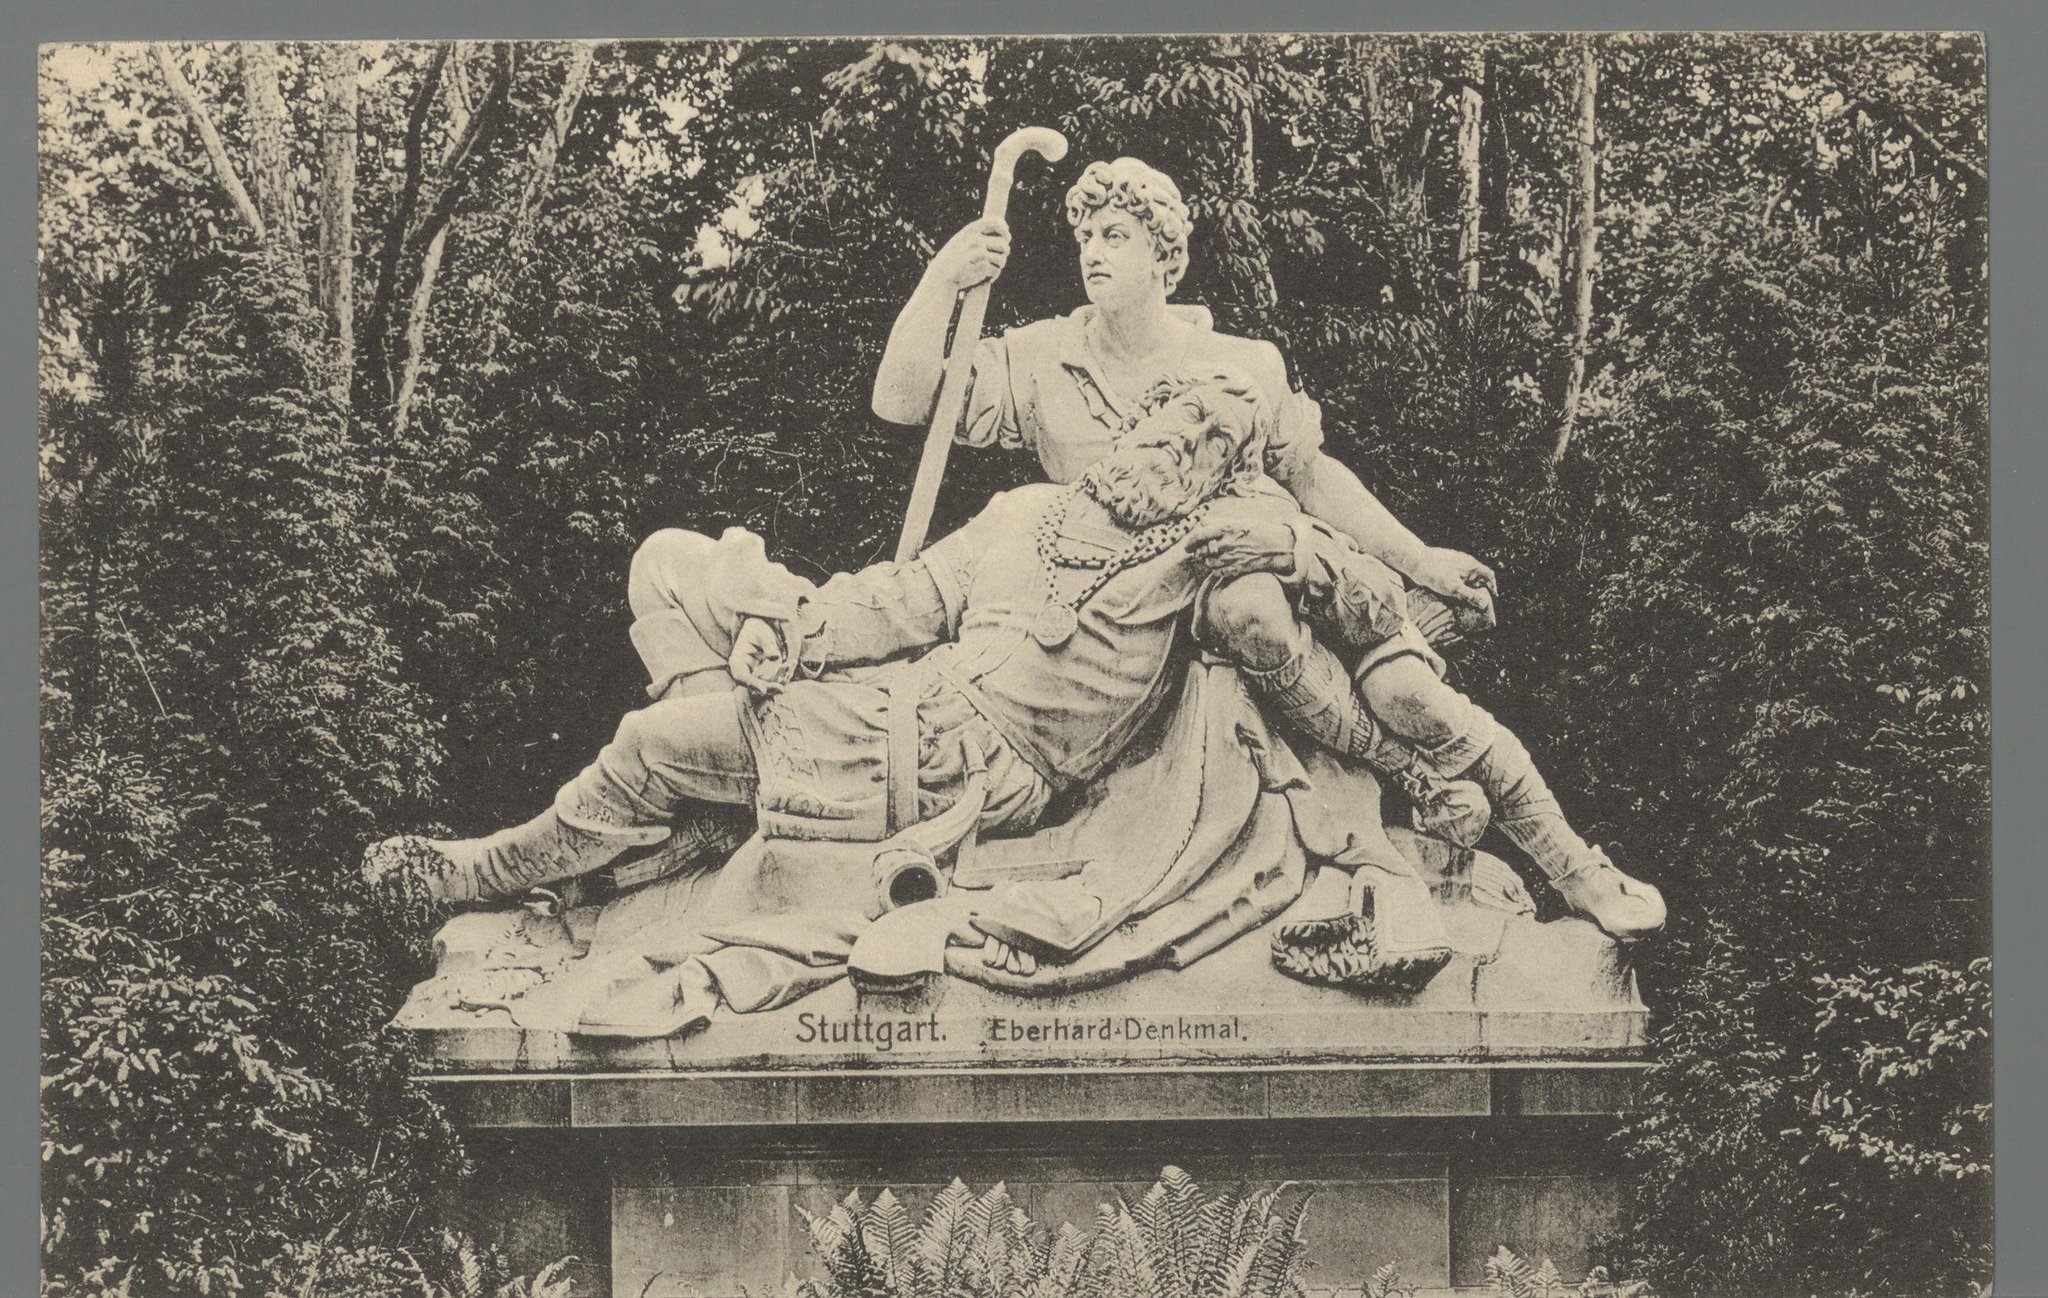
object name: photomechanical print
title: Stuttgart. Eberhard-Denkmal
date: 1905-1909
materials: cardboard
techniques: photograph, writing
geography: stuttgart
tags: monument, statue